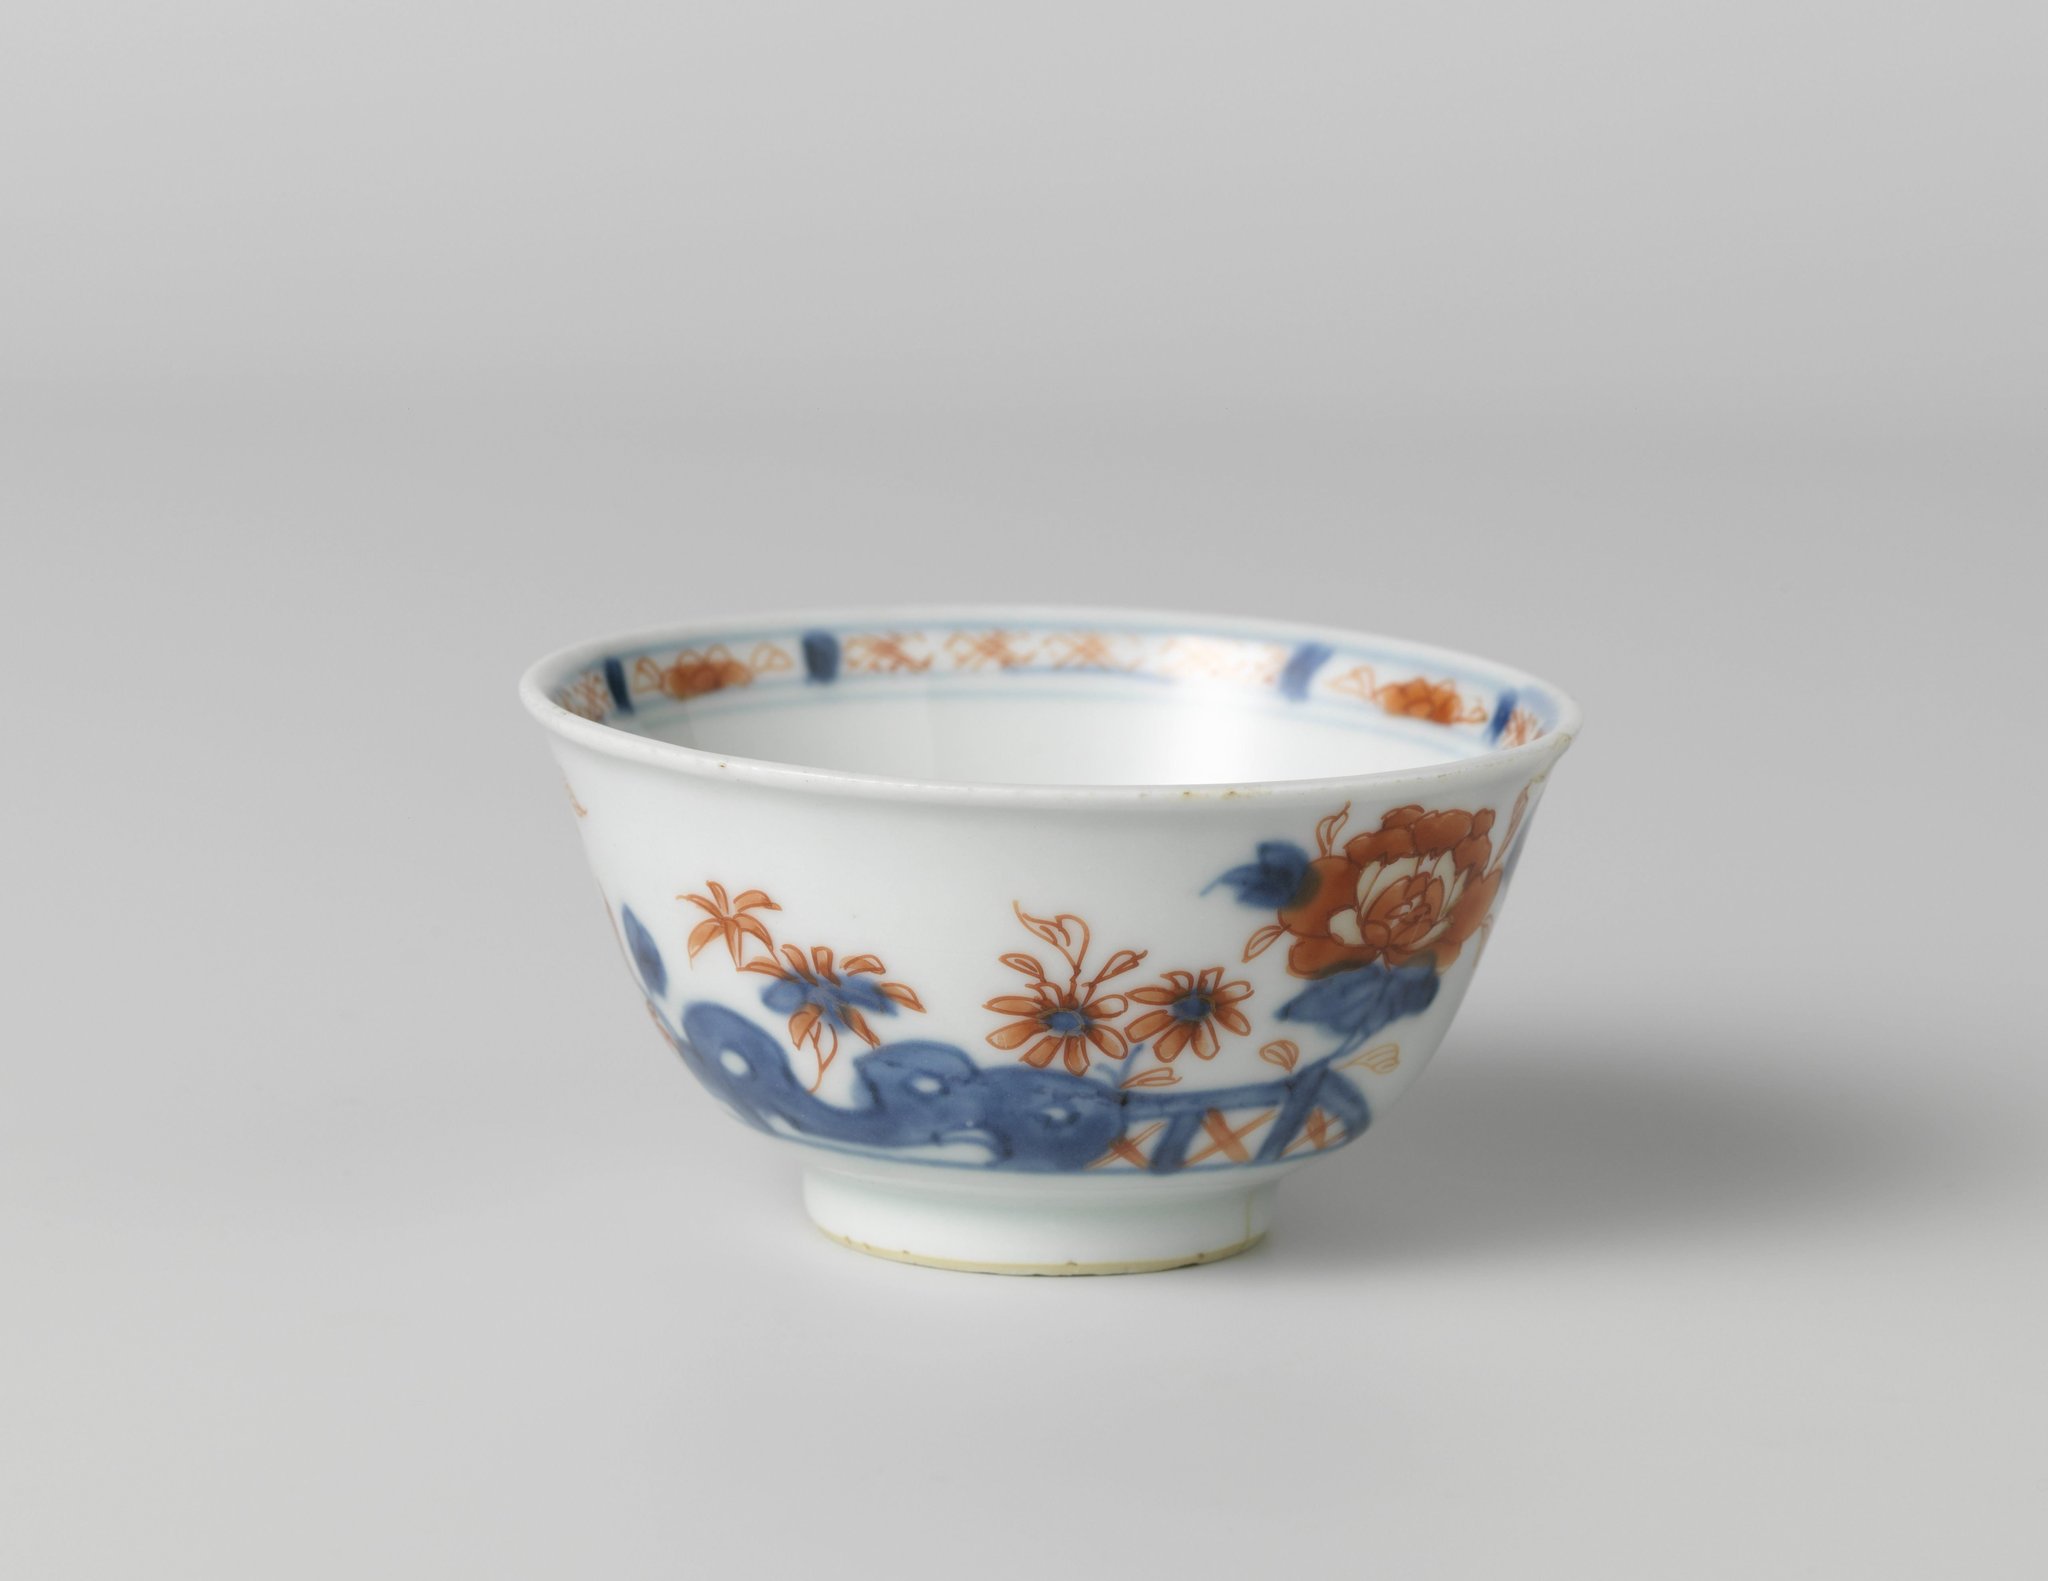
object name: kop en schotel, kop en schotel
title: Cup with flower sprays behind a rock and fence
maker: Anonymous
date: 1750-1774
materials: cobalt, glaze, gold, paint, porcelain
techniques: firing, gilding, turning, vitrification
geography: china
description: Komvormige kop en schotel van porselein, Imari. Beschilderd in blauw, rood en goud met bloeiende takken.